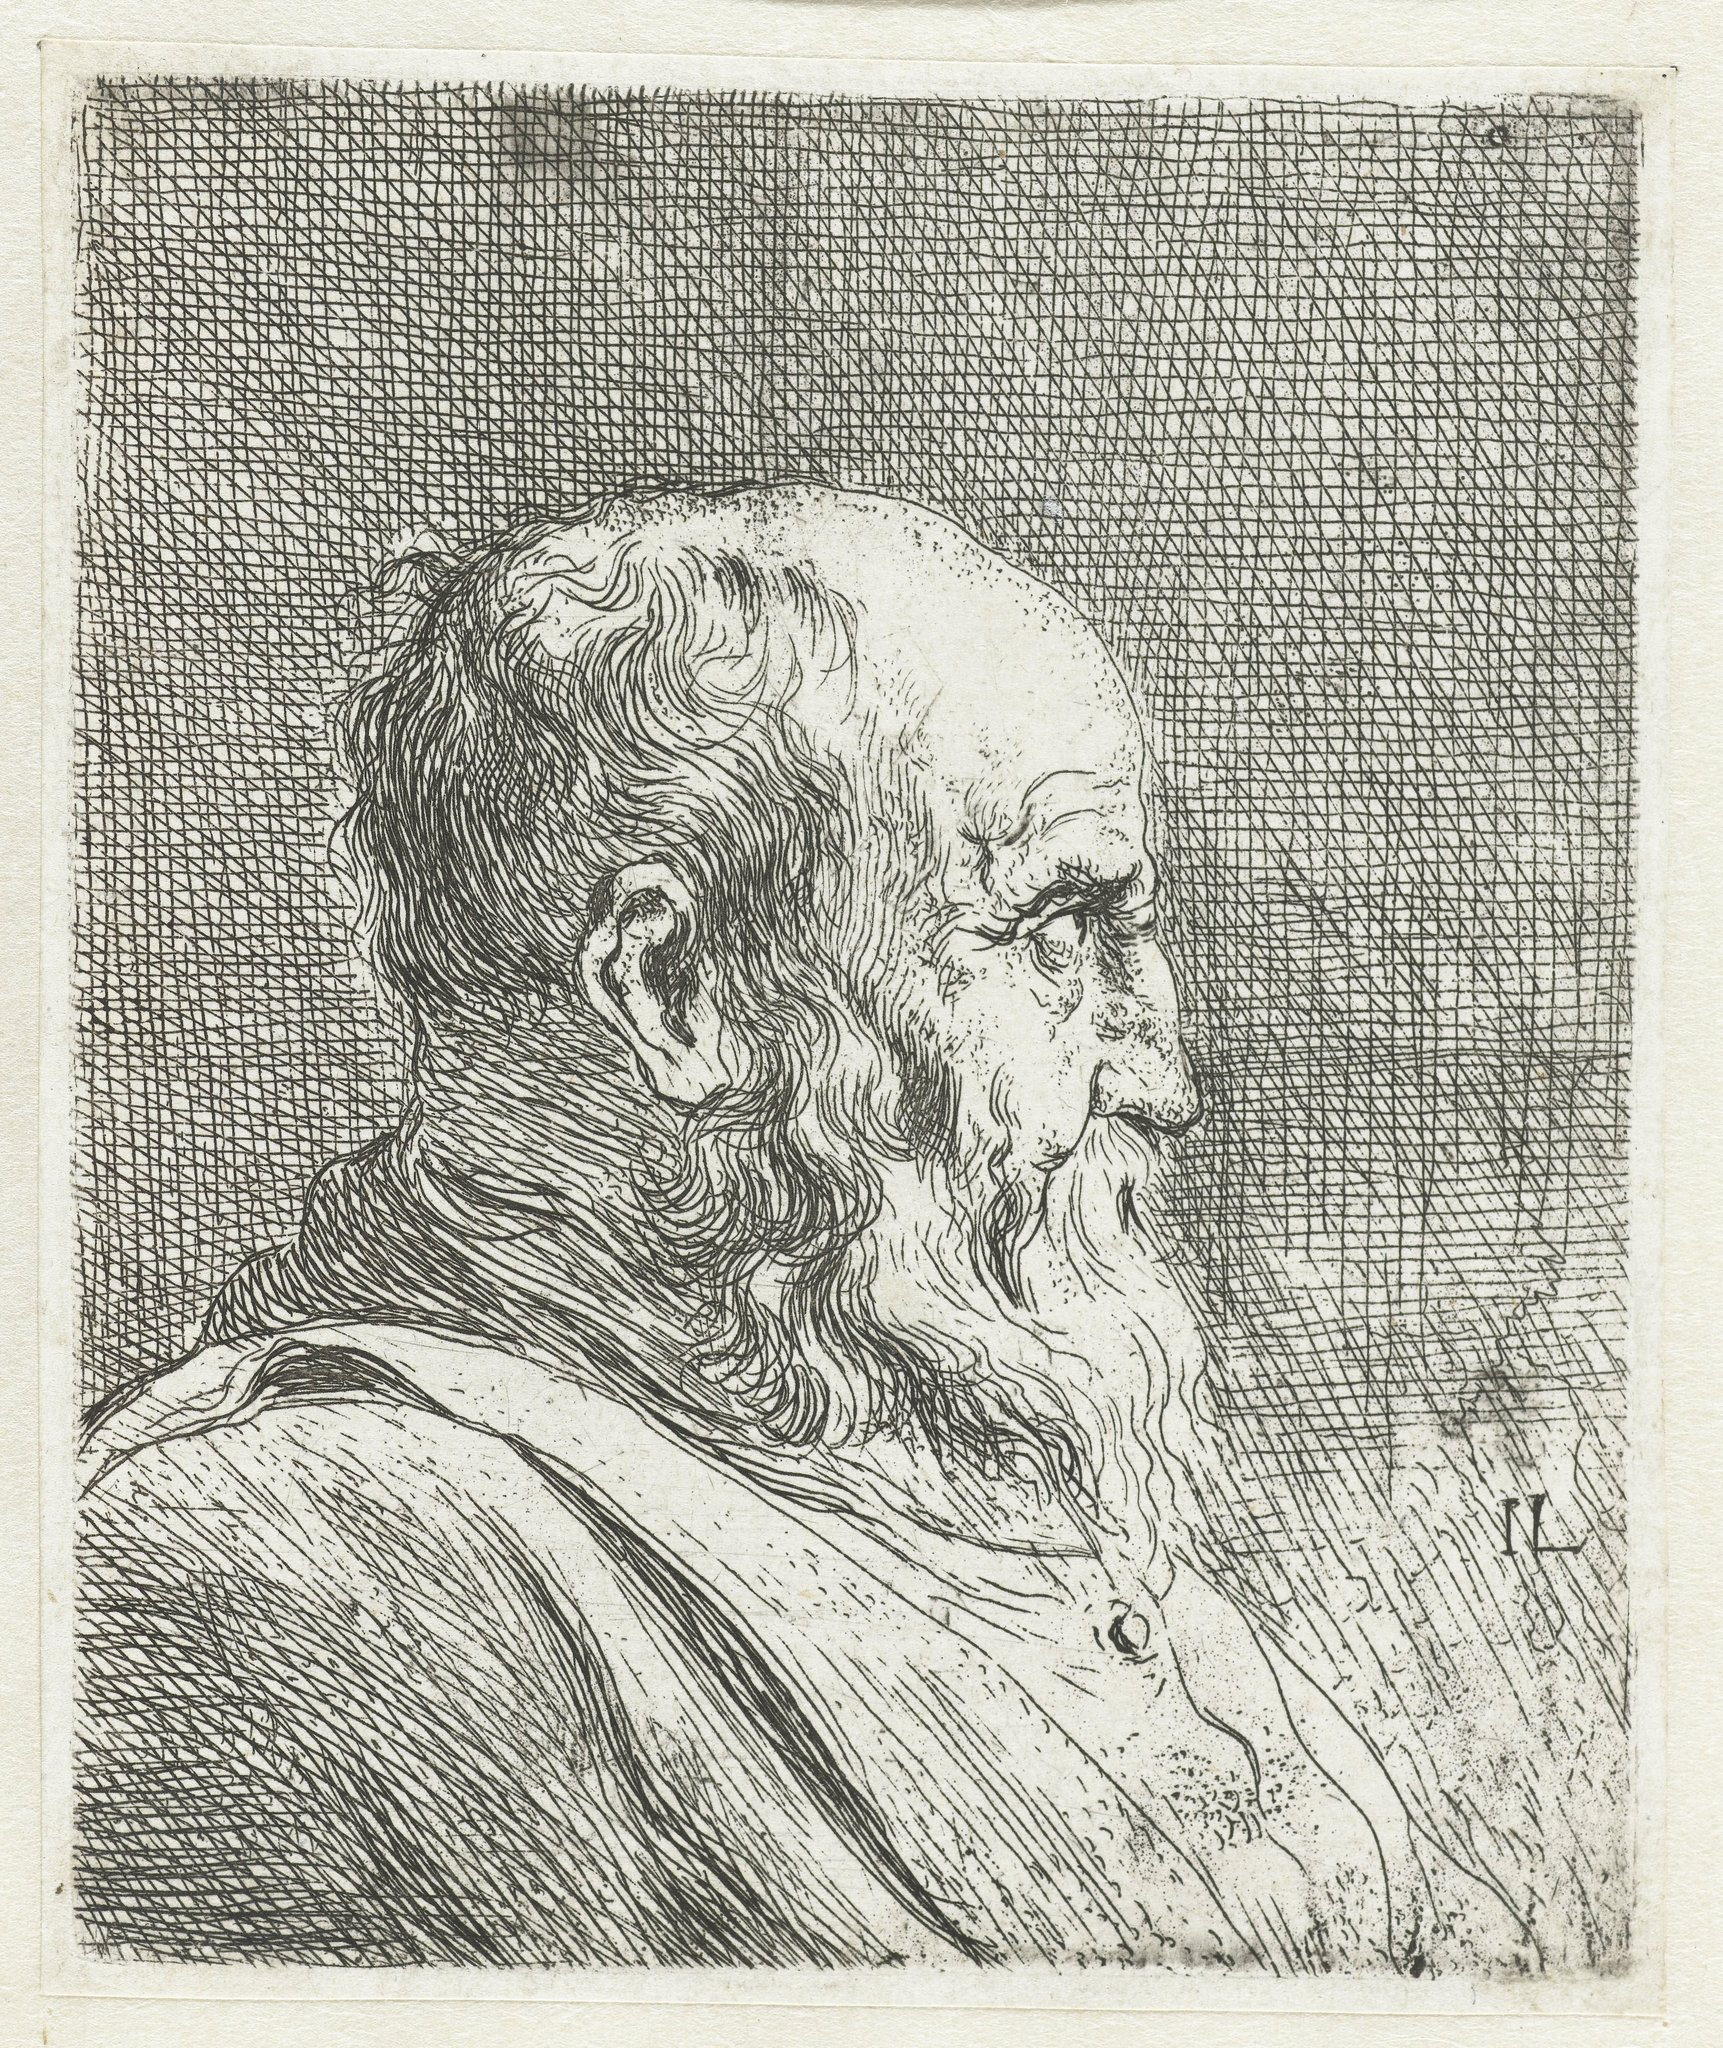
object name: print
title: Borstbeeld van een oude man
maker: jan lievens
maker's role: draughtsman, painter, print maker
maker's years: 1607-1674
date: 1625-1674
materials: paper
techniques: etching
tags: old man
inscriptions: collector's mark: Lugt 2228a